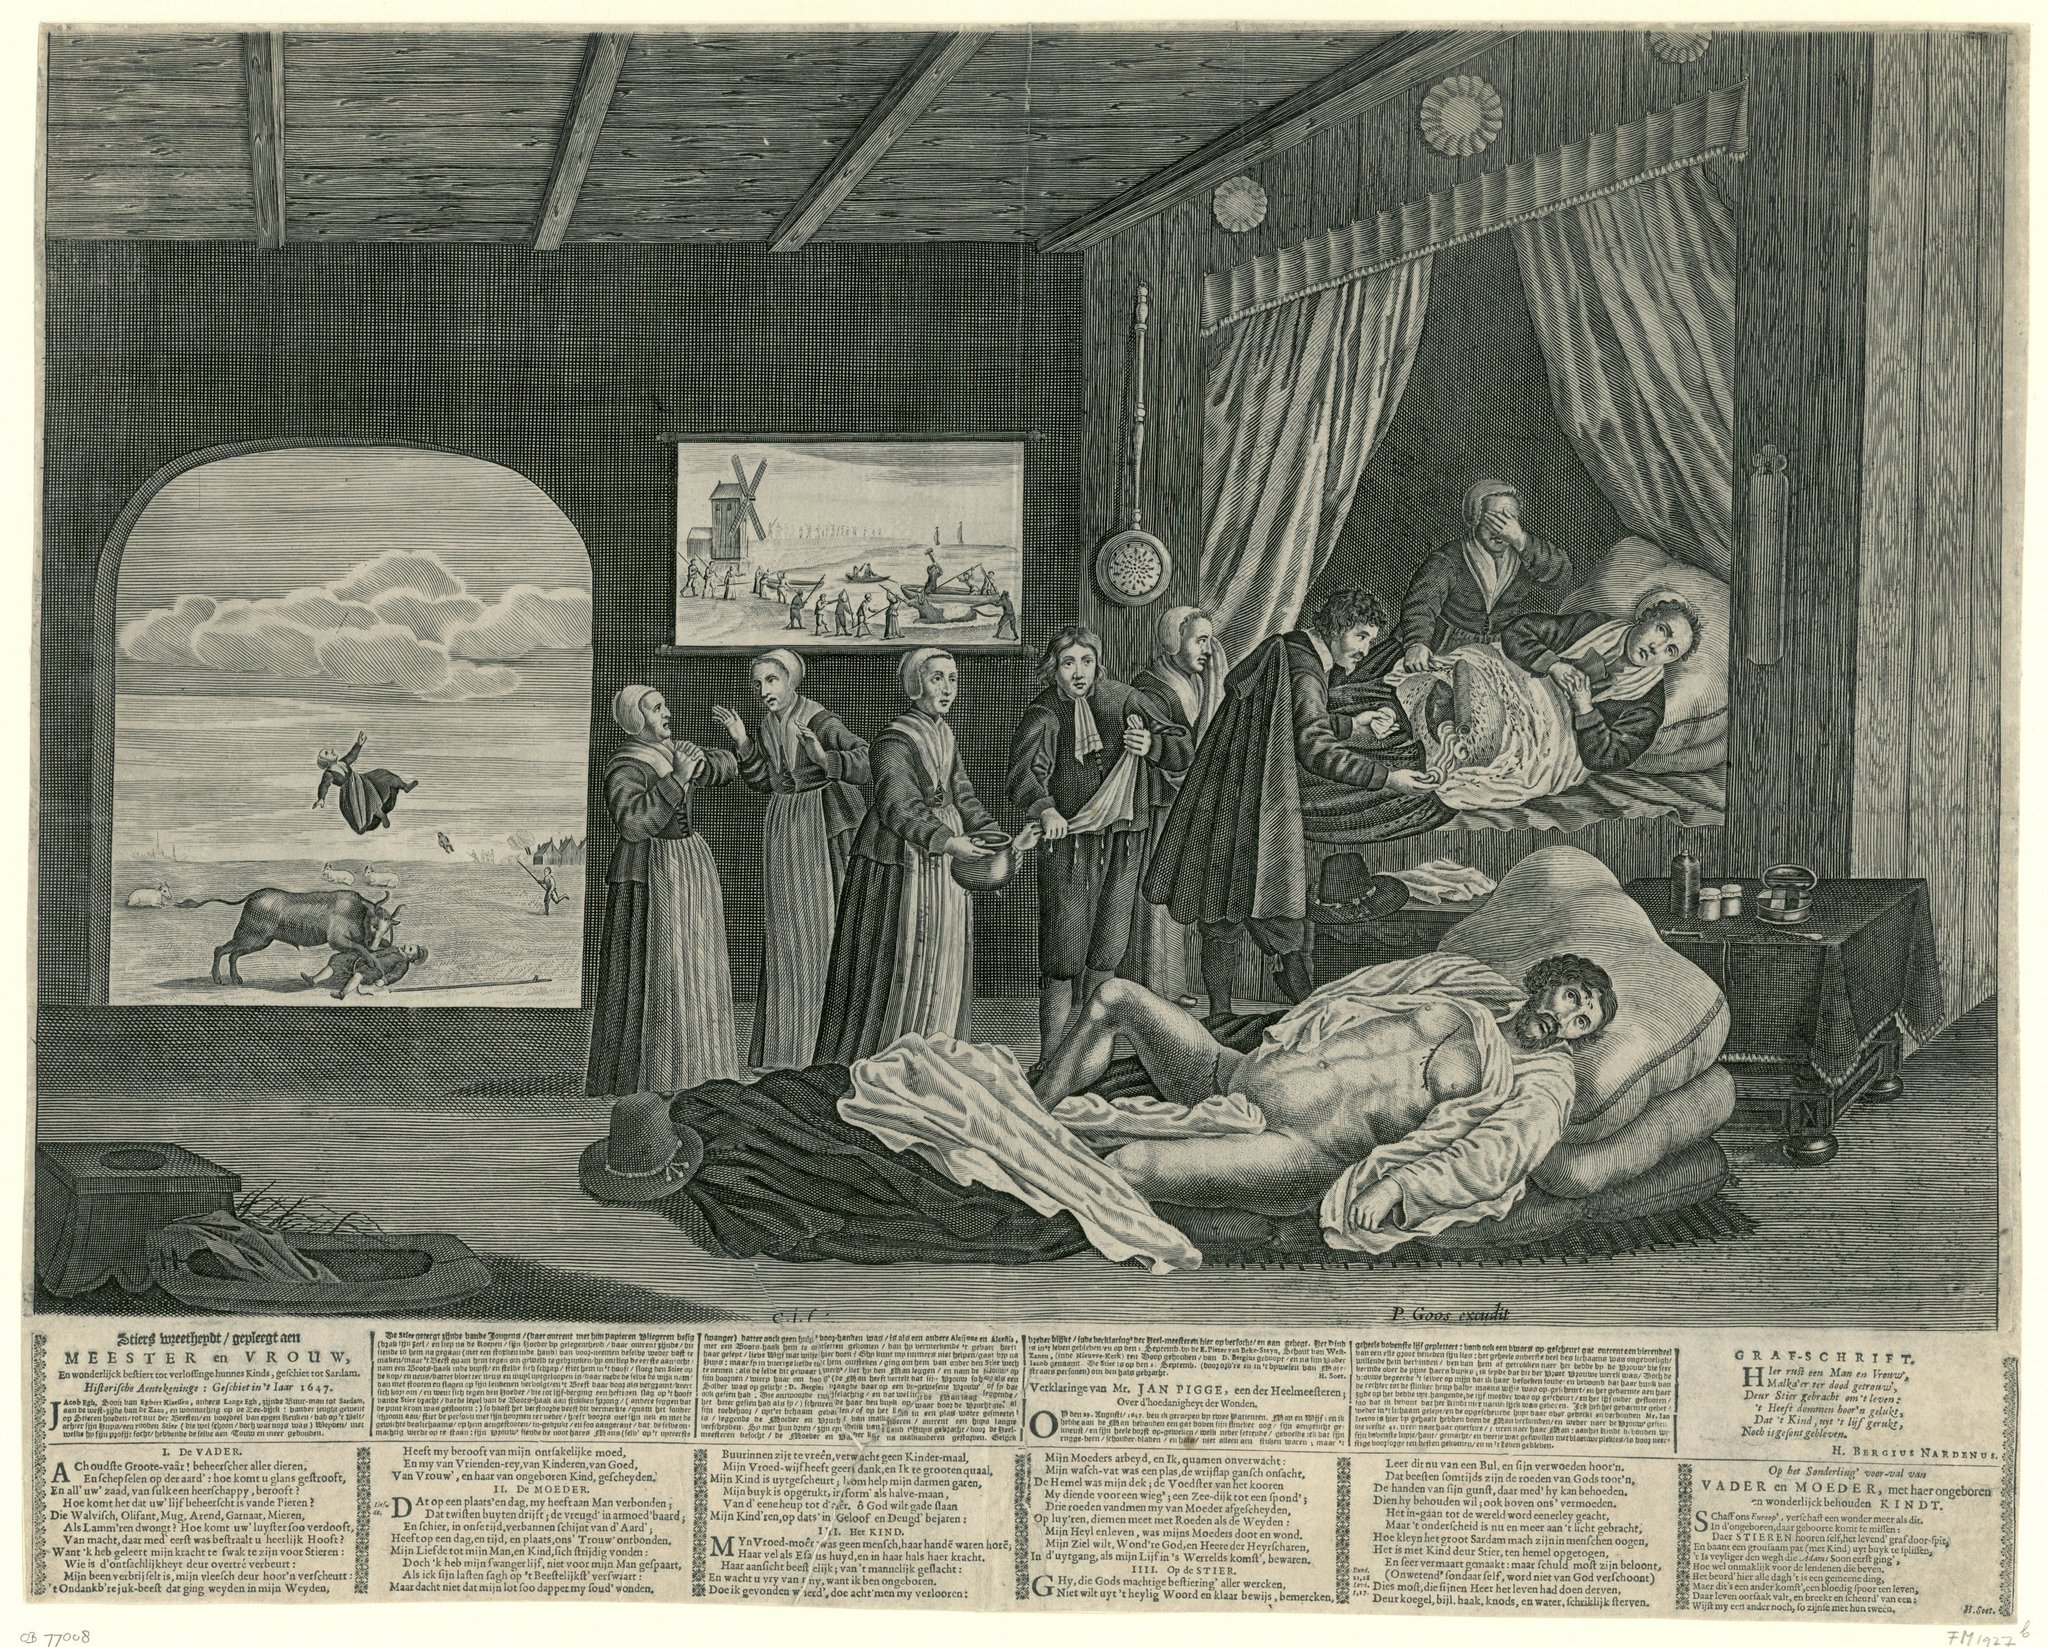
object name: print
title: De wreedheid van de stier, 1647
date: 1647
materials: paper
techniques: engraving, letterpress printing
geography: northern netherlands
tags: bull, difficult and unusual birth, infections and wounds, medical examination, medical treatment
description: Illustratie van de gebeurtenissen die bekend staan als de wreedheid van de stier, 1647. De boer en zijn zwangere echtgenote die op 29 augustus 1647 te Zaandam door een stier werden aangevallen. De zwangere vrouw wordt op de horens genomen waarbij het kind uit de buik wordt geslingerd. De prent toont een interieur waarin de dodelijke gewonde boer en boerin liggen. Op de achtergrond is in twee scènes te zien hoe de man en de vrouw door de stier worden aangevallen en hoe de stier uiteindelijk wordt afgemaakt. Onder de voorstelling een beschrijving van de gebeurtenissen, verschillende verzen over de hoofdrolspelers en een verklaring van de betrokken arts, in 6 kolommen. Heruitgave van de oorspronkelijke prent.